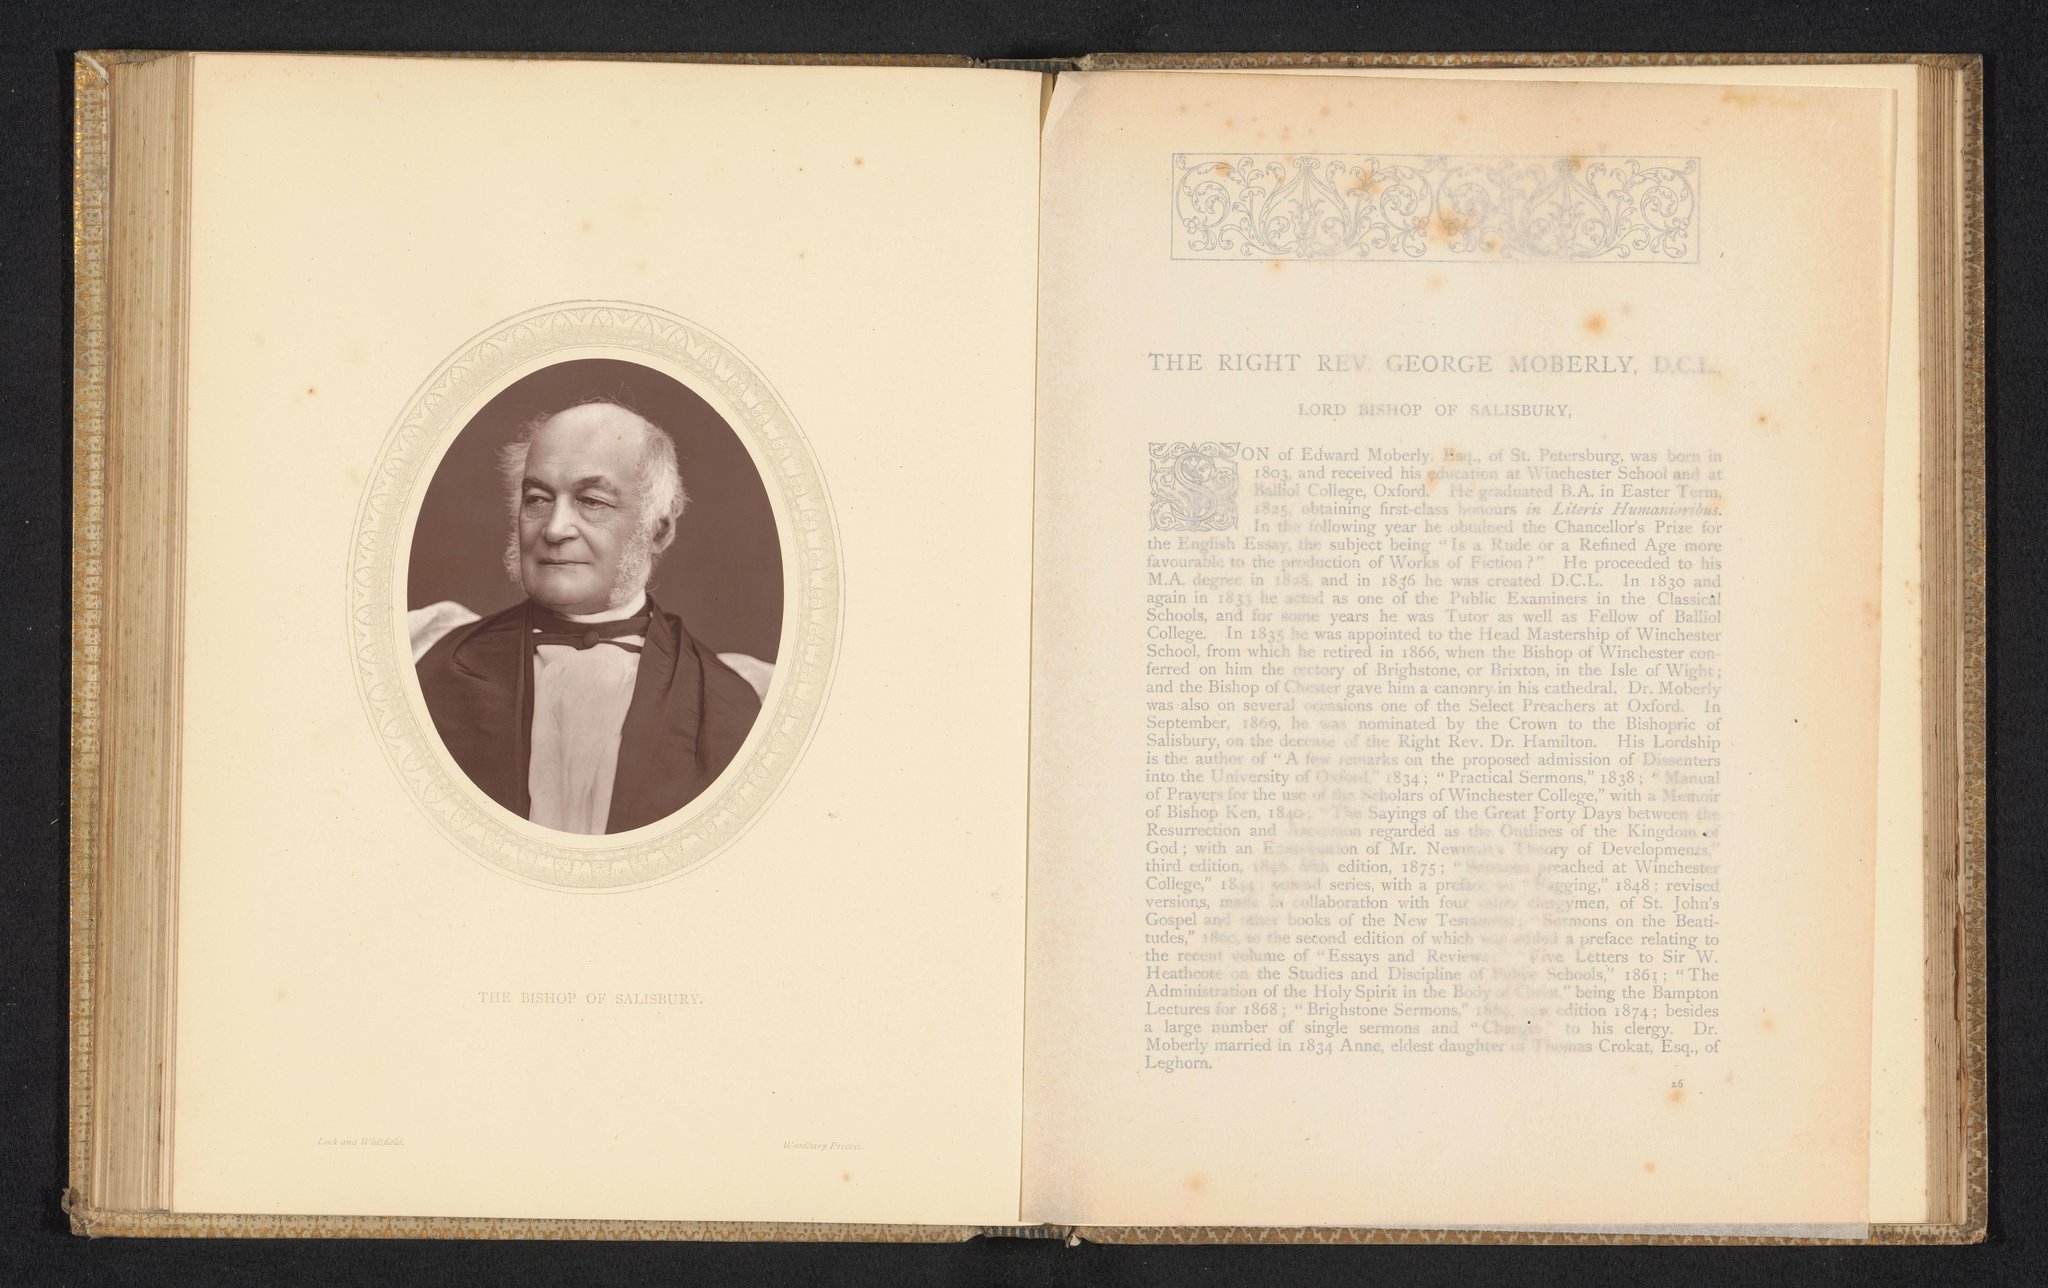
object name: page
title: The bishop of Salisbury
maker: Anonymous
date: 1871-1876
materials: paper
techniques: woodburytype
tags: archbishop, bishop, etc. (roman catholic), historical persons (portraits and scenes from the life) (+ (full) bust portrait)